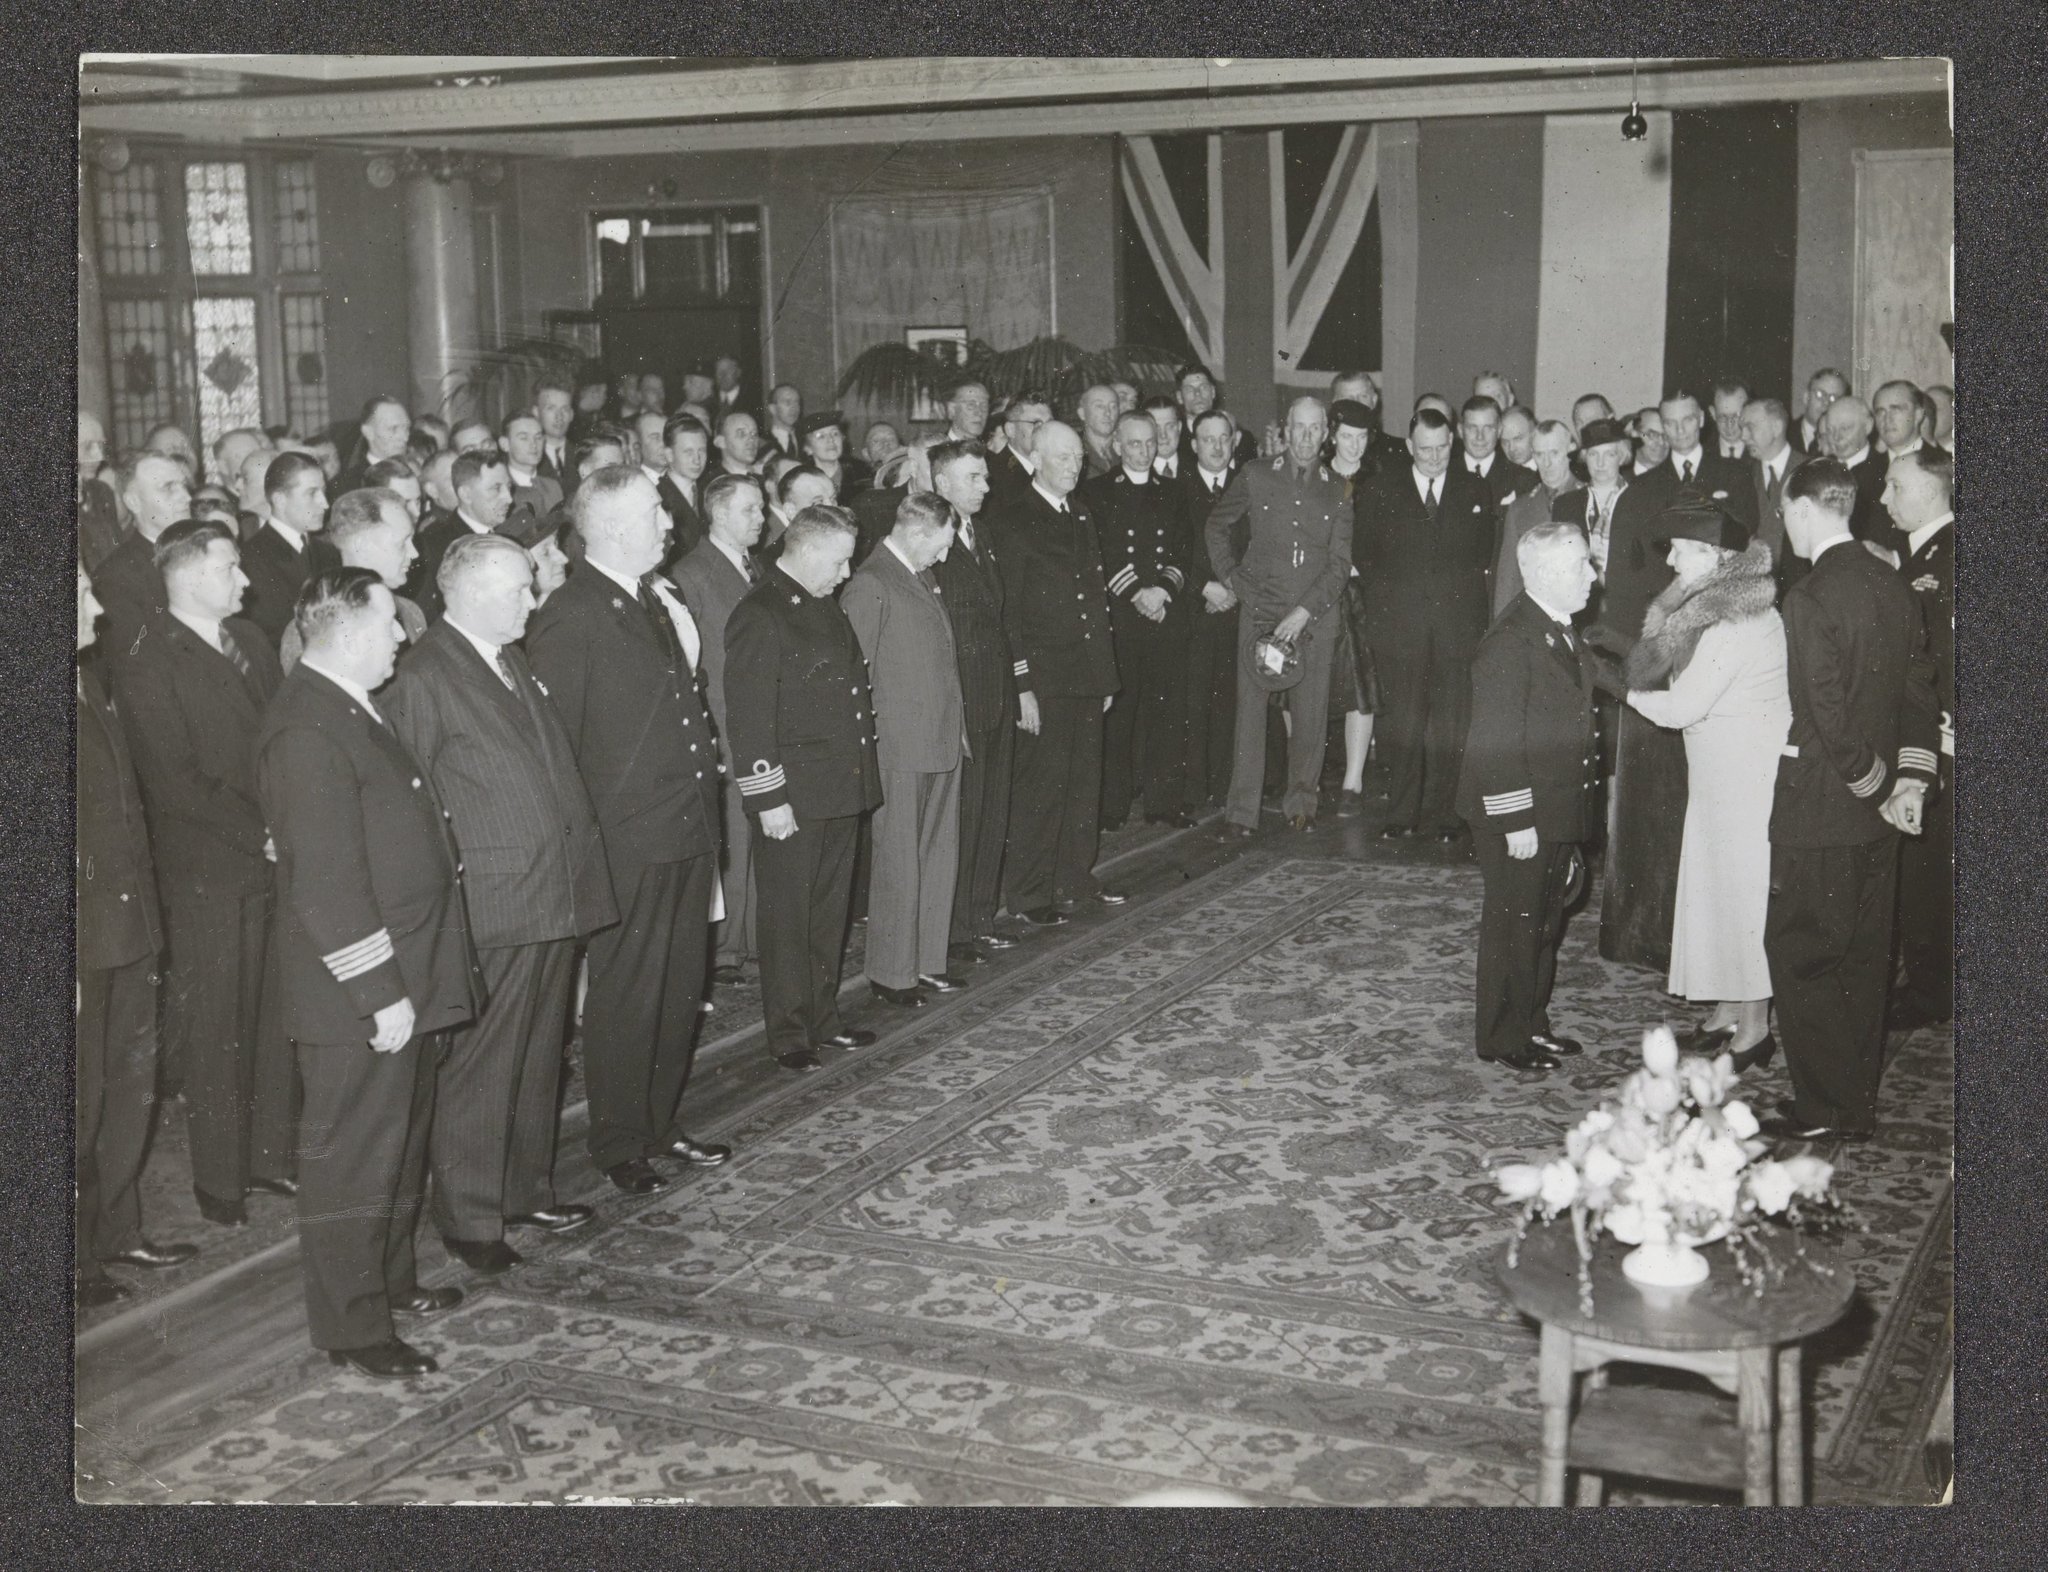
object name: photograph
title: Koningin Wilhelmina speldt een onderscheiding op het revers van een oude zeeman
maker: Anonymous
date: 1941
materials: photographic support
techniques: gelatin silver print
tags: print maker, wilhelmina of the netherlands, london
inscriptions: inscription: ‘Investiture in sailors Home, London 5/5/1941’, stamp: ‘Photo archief R.V.D.’, stamp: ‘copyright photograph supplied by Wide World Photos 8, sallisbury square Fleet Street, London , England’, inscription: ‘opening tehuis voor Nederlandse Zeelieden in Londen. 42 zeelieden van Nederlandse koopvaardij ... openbare plechtigheid in Engeland ... Wilhelmina bijgewoond werd.’, inscription: ‘HIE 93’